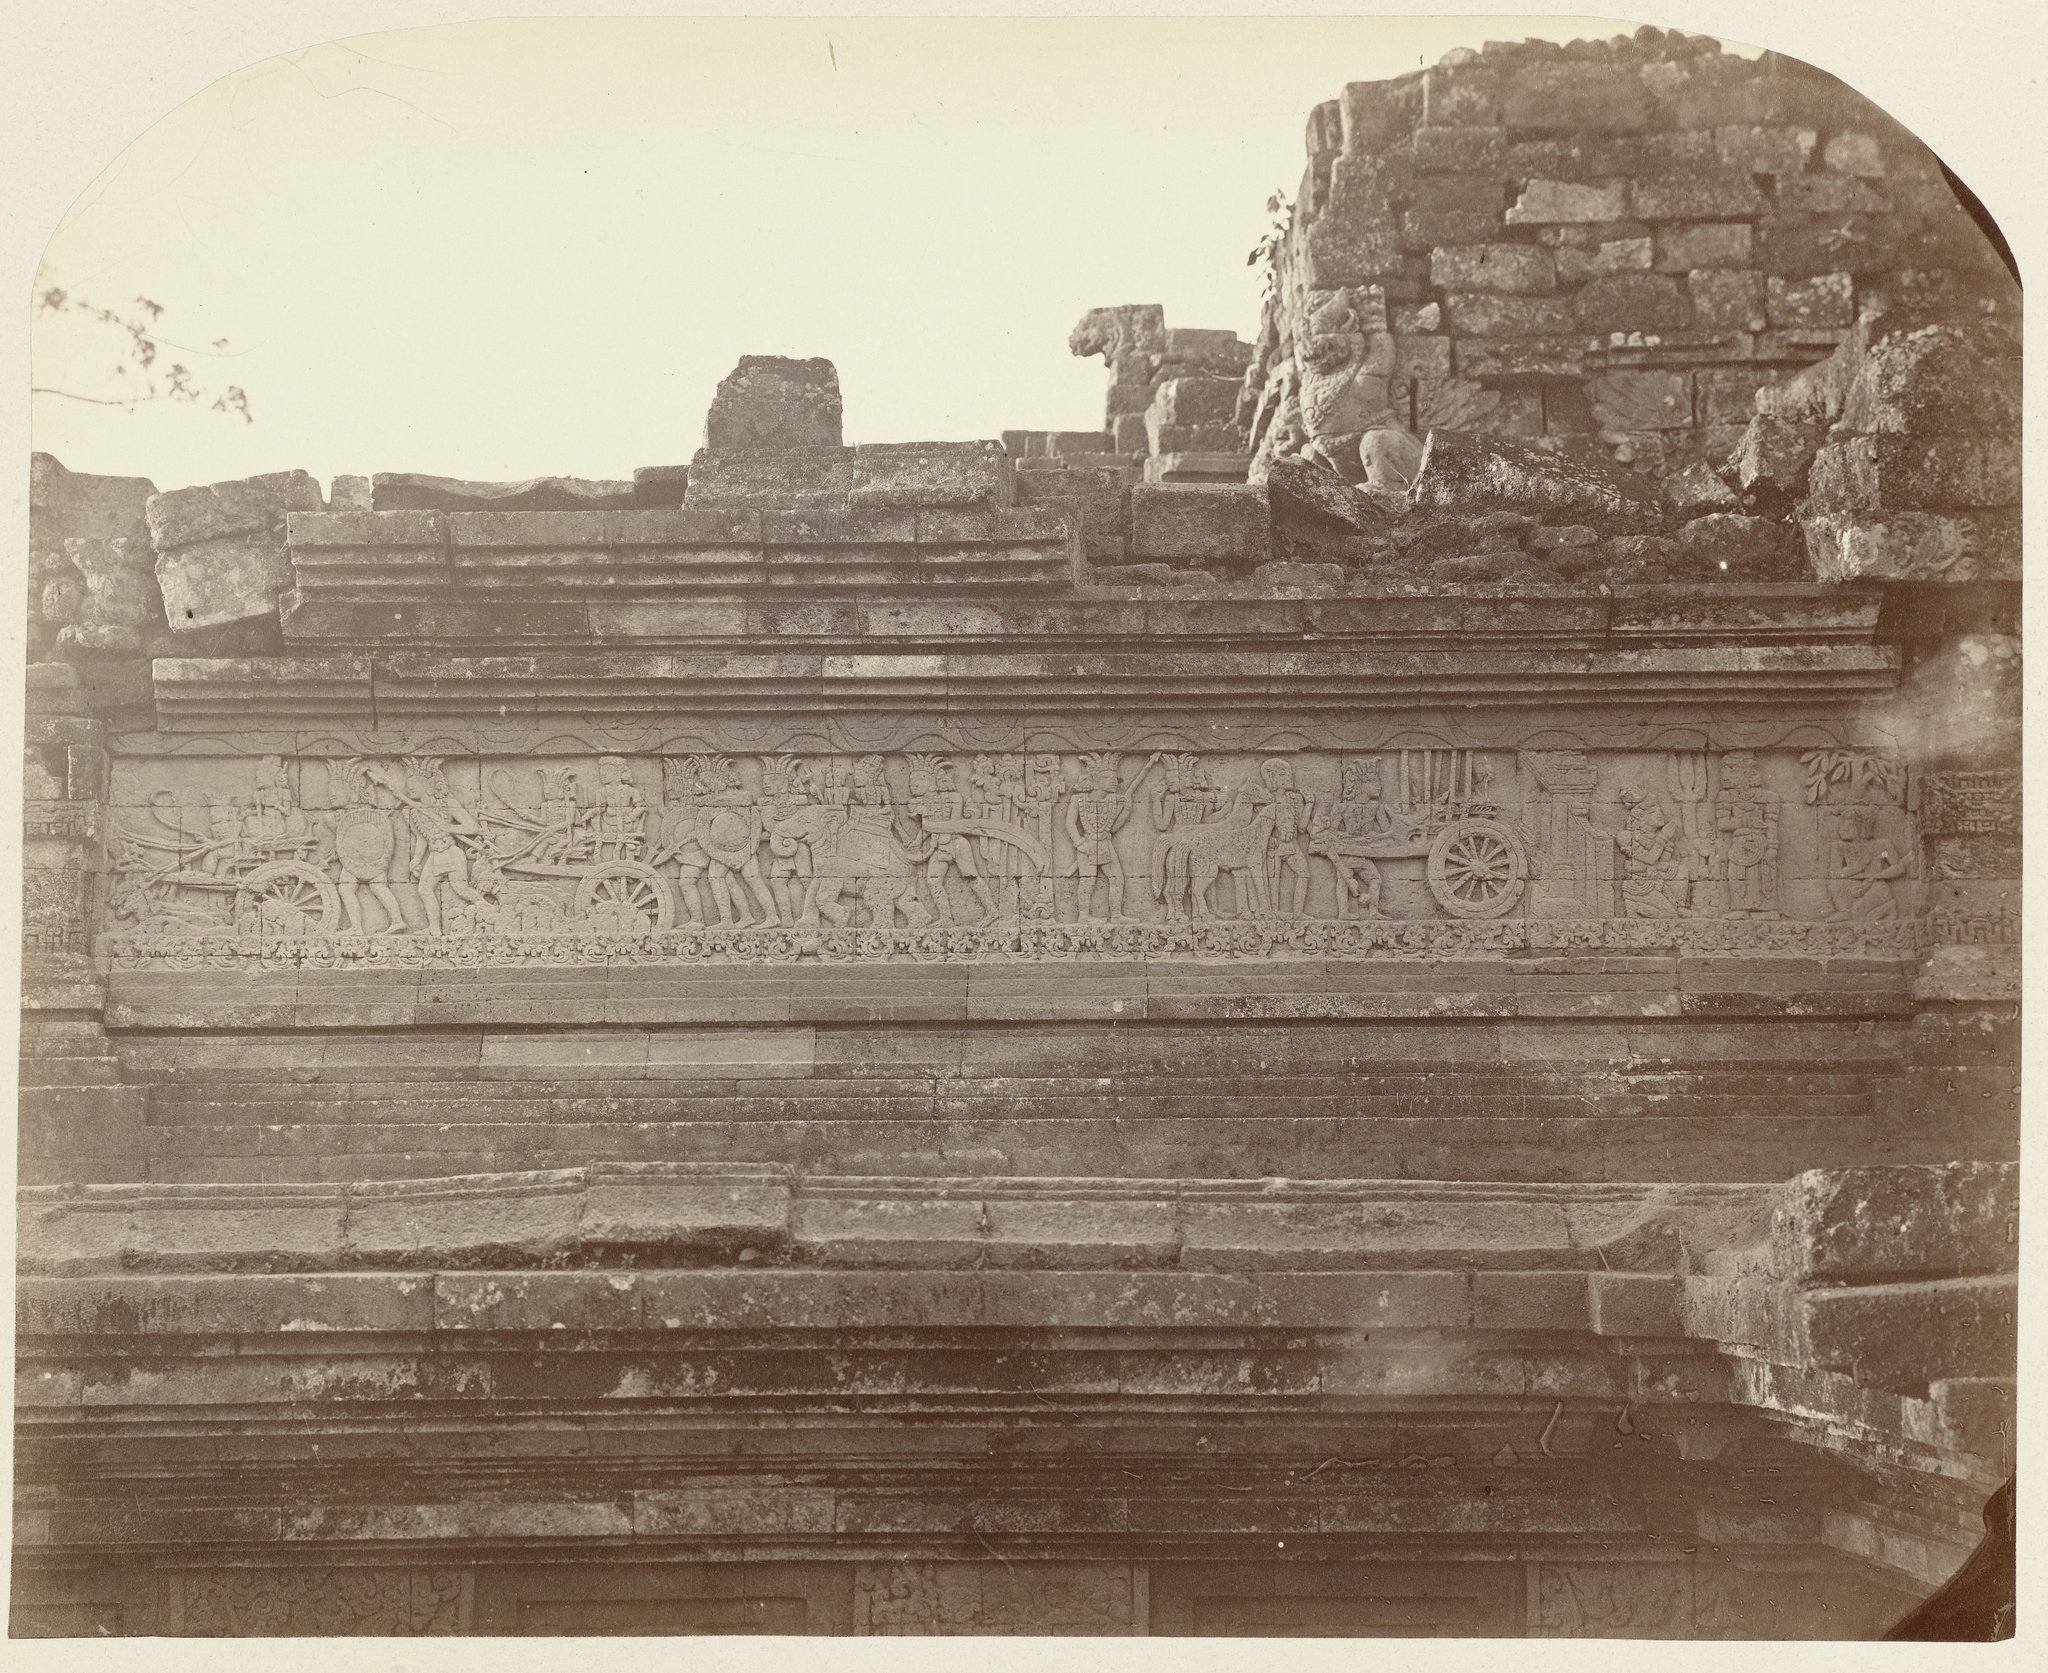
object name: photograph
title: Basreliëf met Krishna verhaal in tempelcomplex candi Panataran aan de zuidzijde.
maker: isidore kinsbergen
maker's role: fotograaf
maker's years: 1821-1905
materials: cardboard, paper, photographic support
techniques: albumen print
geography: java